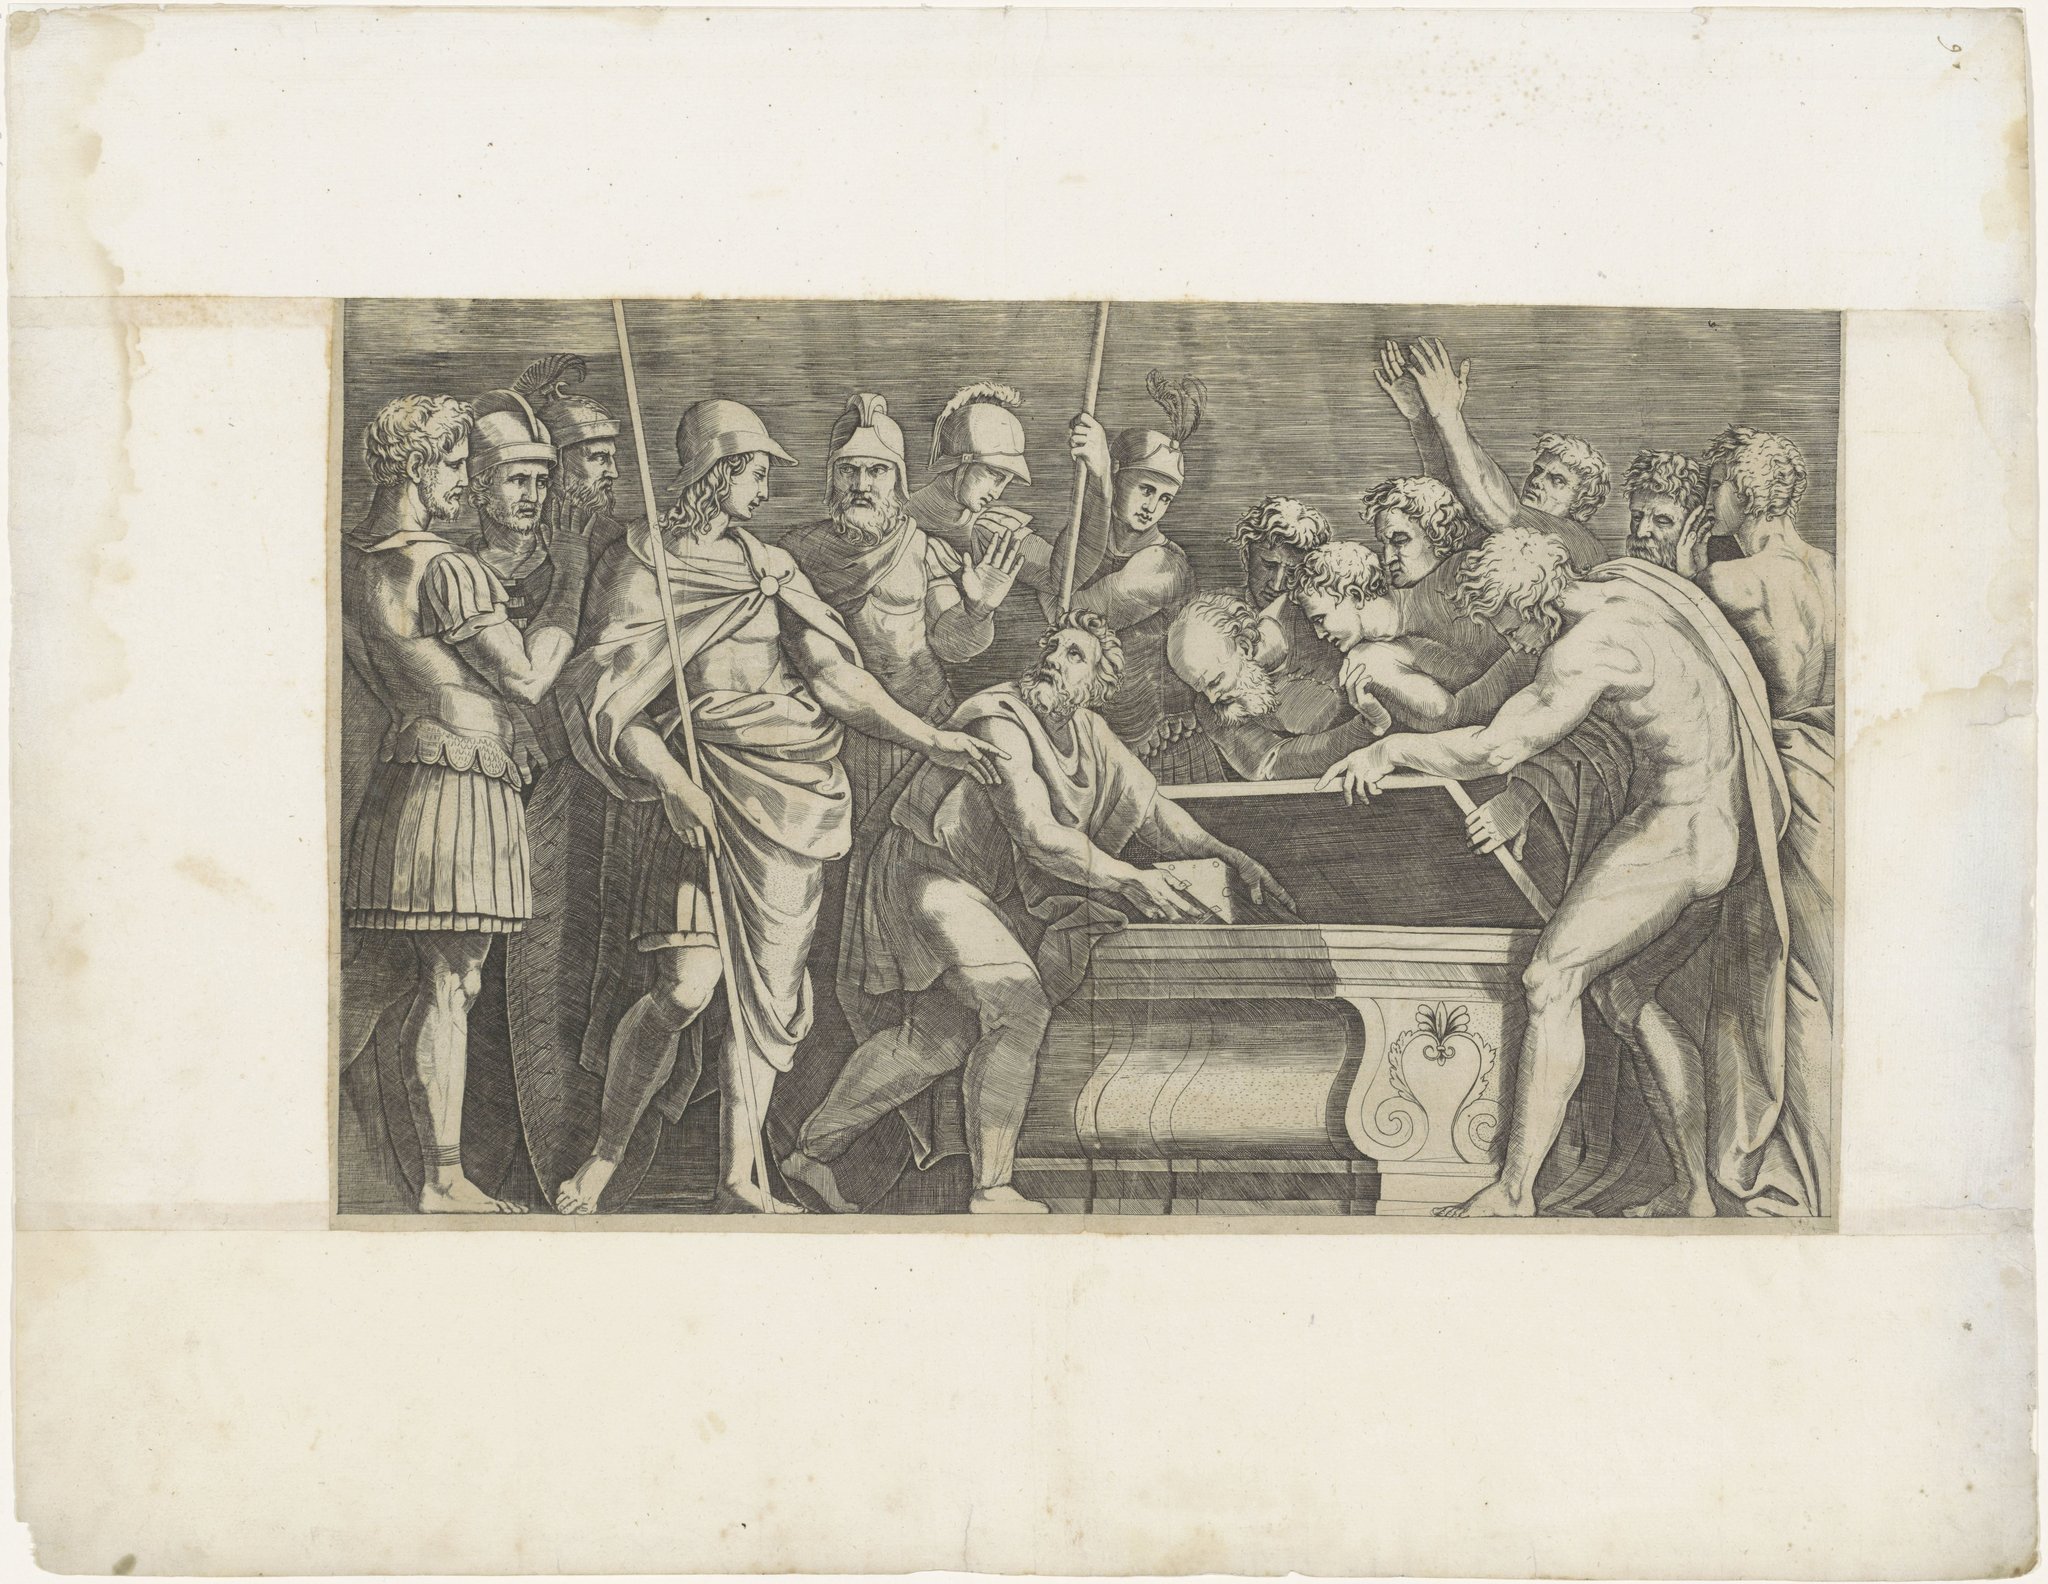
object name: print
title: Alexander de Grote laat de werken van Homerus veilig opbergen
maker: Anonymous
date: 1515-1570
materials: paper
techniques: engraving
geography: rome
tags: (story of) alexander the great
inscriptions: collector's mark: Lugt 2760, collector's mark: Lugt 2228, watermark, number: ‘9’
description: Folio 9 uit het prentalbum van Johann Georg I. Zobel von Giebelstadt (1543-07-20 Röttingen - Bamberg 1580-09-07), de latere bisschop van Bamberg. Het album was vermoedelijk samengesteld tussen 1568 en 1570 in Venetië. Het werd in 1999 uit elkaar genomen door een antiquair. De in totaal 124 folio's met prenten uit het "Zobel Album", werden aangekocht door verschillende musea en privéverzamelingen. De grootste groep (68 folio's) bevindt zich in de collectie van het Rijksmuseum. Spiegelbeeldige kopie naar een prent door Marcantonio Raimondi (RP-P-OB-12.125). Raimondi kopieërde de voorstelling van een tekening door Rafaël (Oxford, Ashmolean Museum, inv. nr.: WA1935.152), welke diende als een voorstudie voor het fresco door Rafaël op de noord wand van de Stanza della Segnatura (Stanze di Raffaello) in het Apostolisch paleis, deel van de Vaticaanse musea.